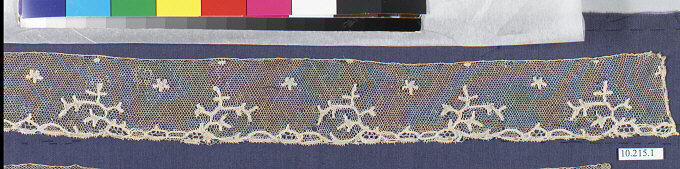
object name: piece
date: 1801-1900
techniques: lace